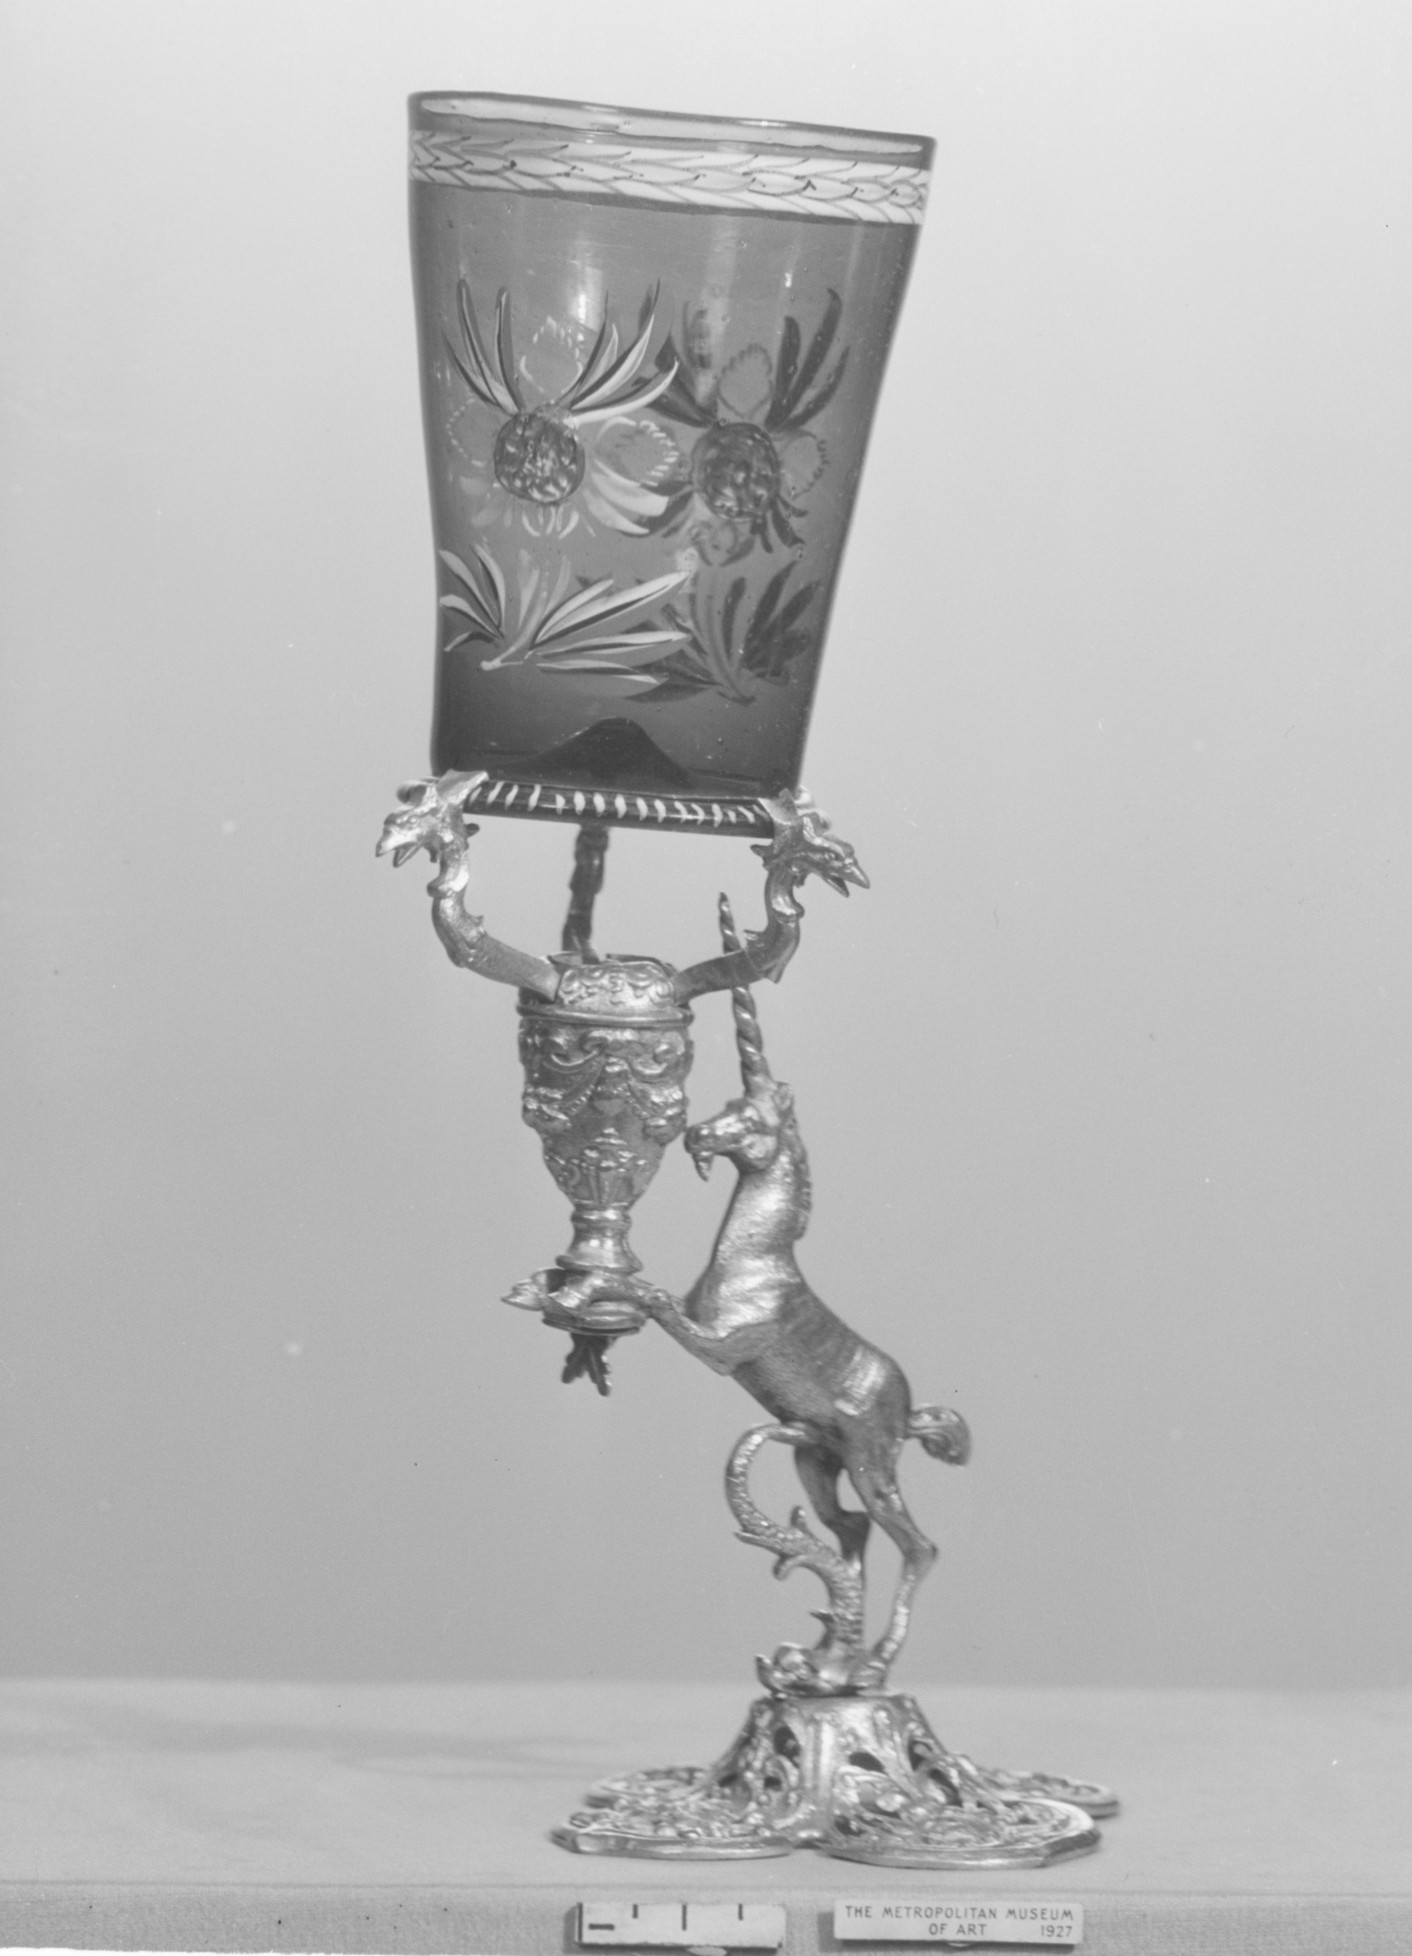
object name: beaker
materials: gilt bronze, glass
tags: birds,unicorns,flowers